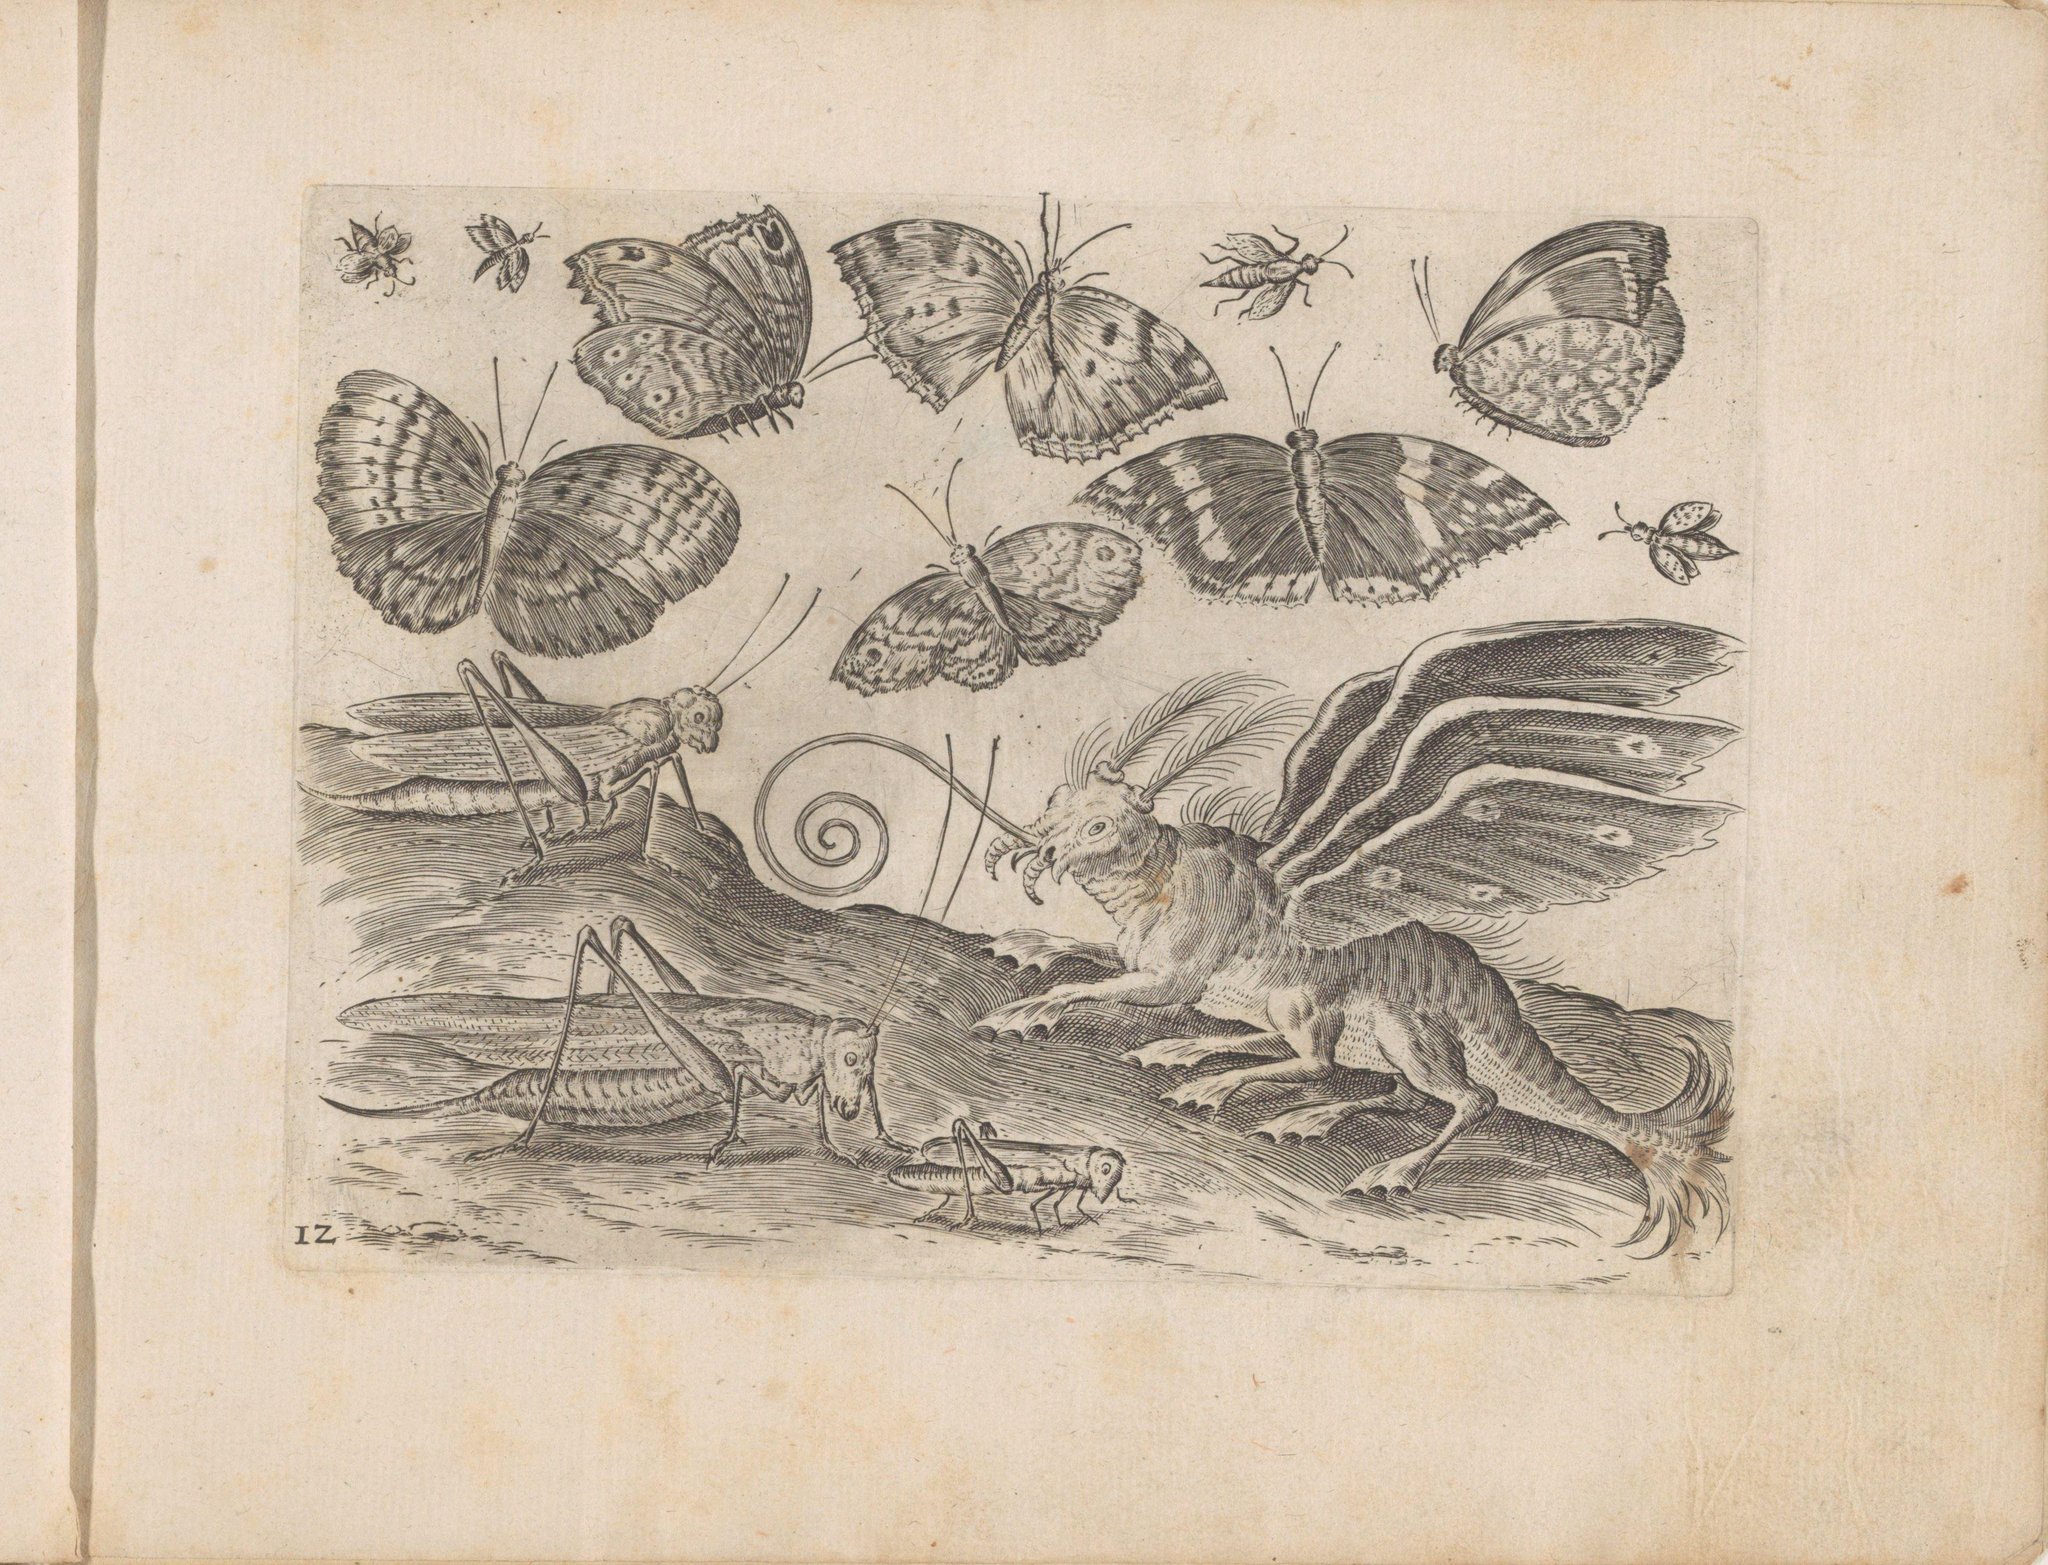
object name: print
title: Dieren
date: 1581-1600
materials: paper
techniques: engraving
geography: netherlands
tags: insects: butterfly, insects, insects: grass-hopper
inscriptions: inscription: ‘12’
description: Verschillende insecten: rechtsvoor een monsterinsect en enkele sprinkhanen. Daarboven verschillende vlinders. Prent maakt deel uit van een album.